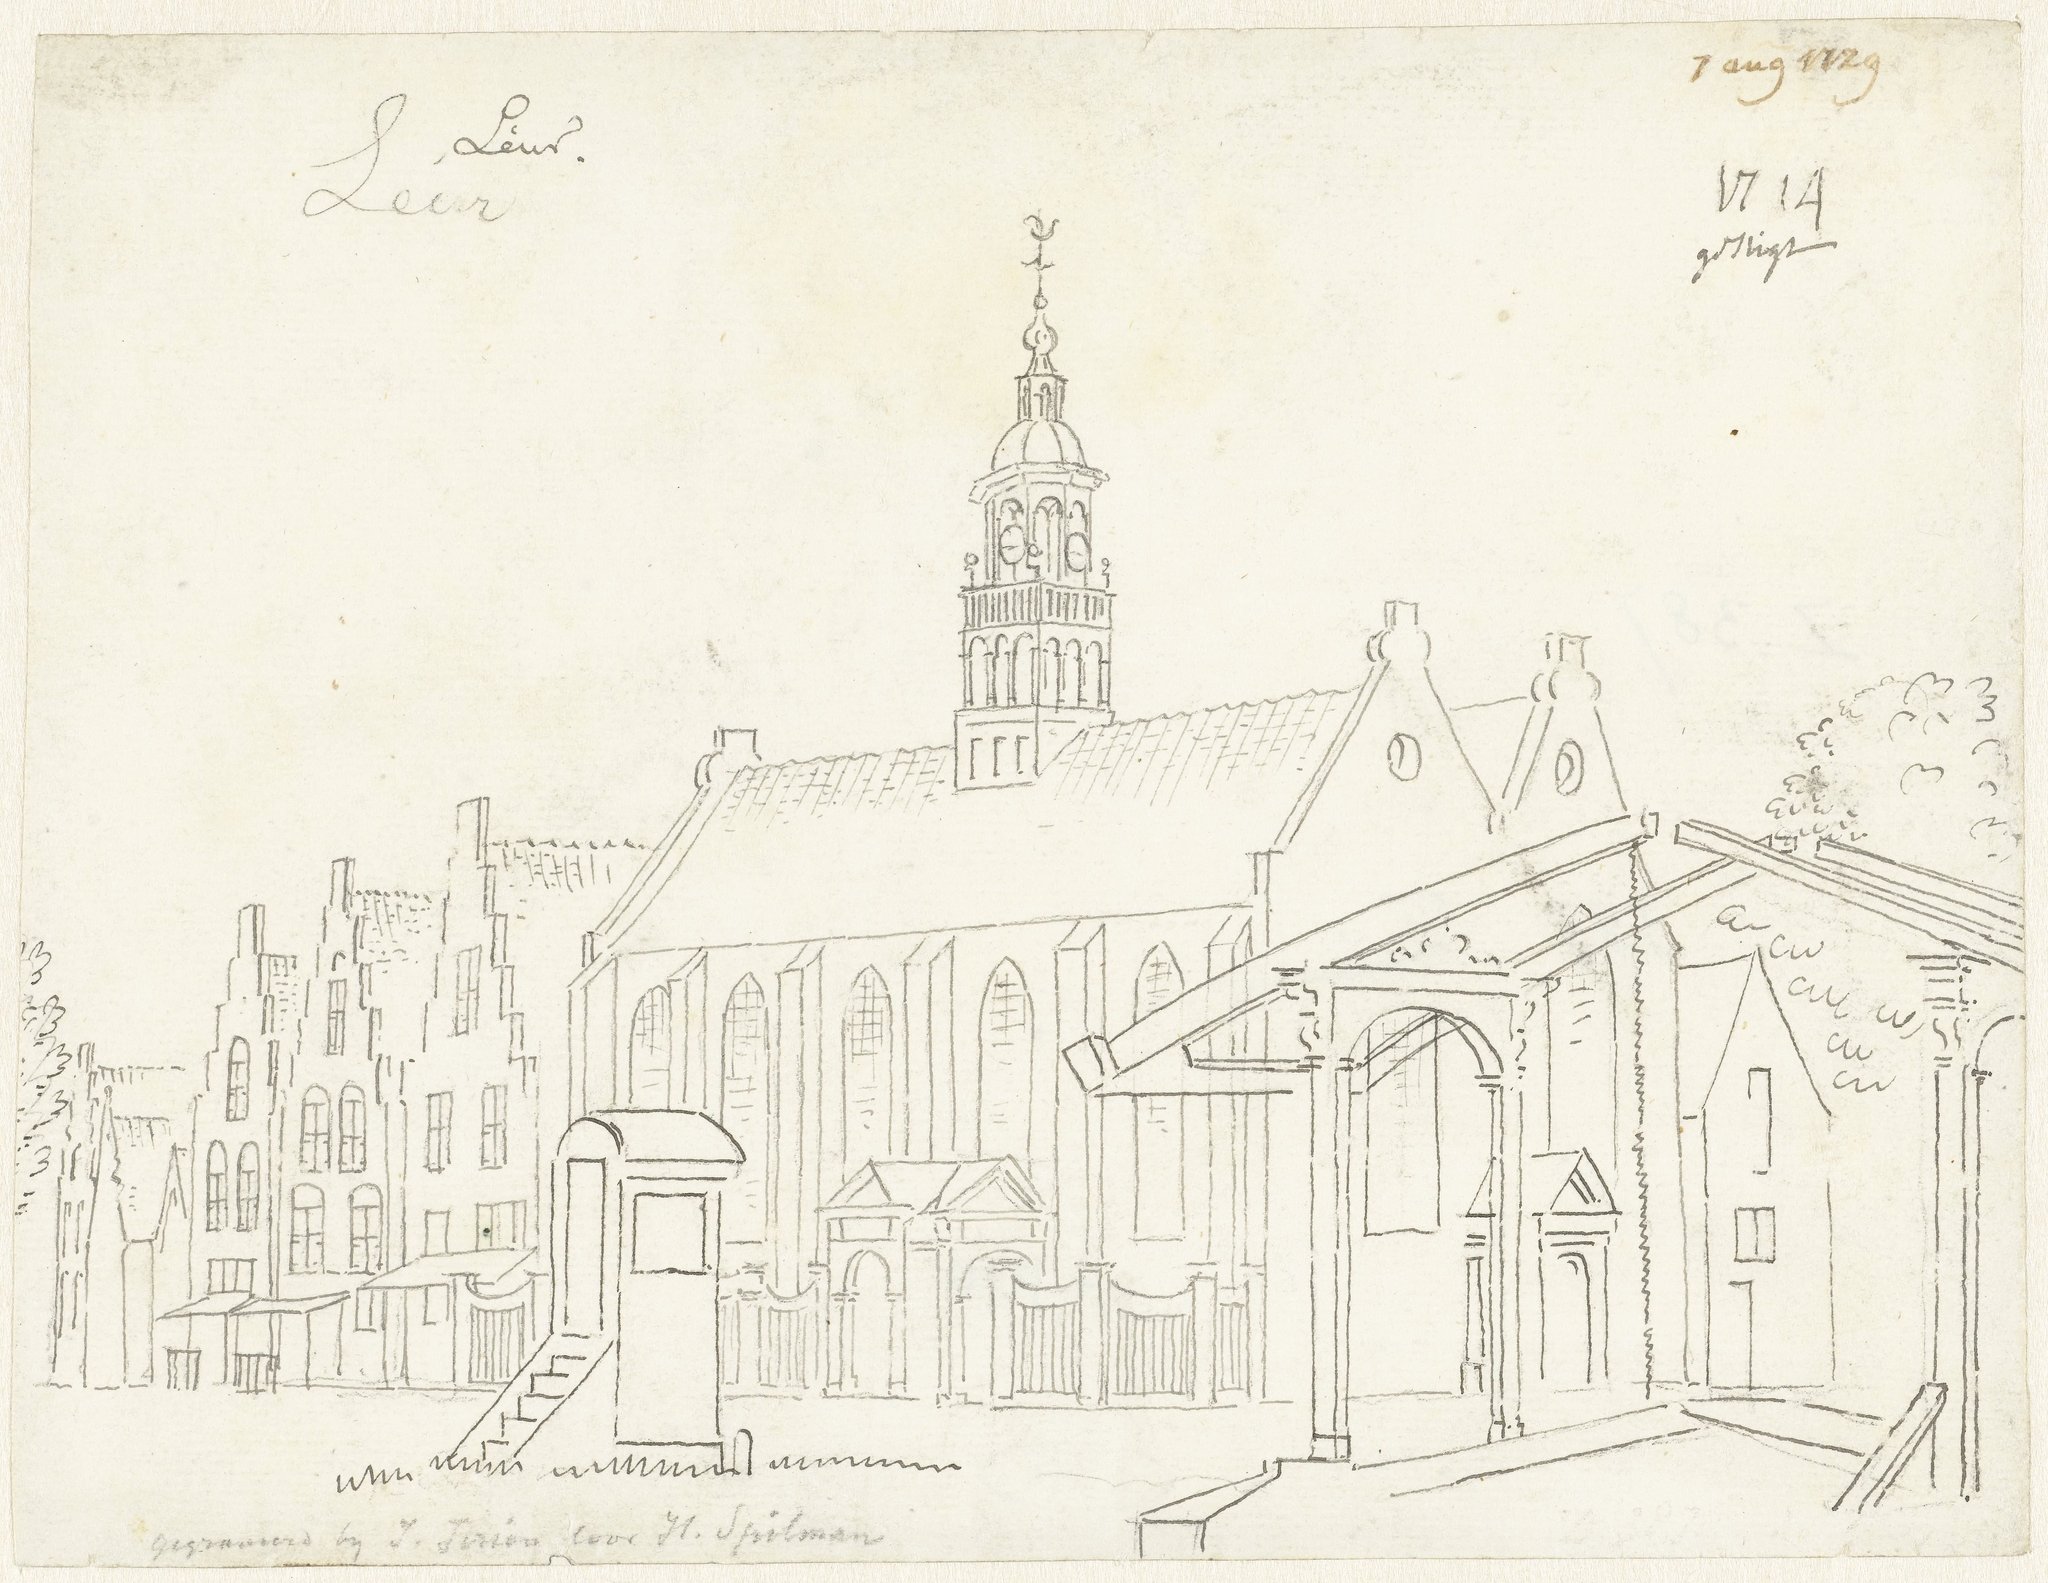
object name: drawing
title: De kerk en een ophaalbrug in het dorp Leur, Brabant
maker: cornelis pronk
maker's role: draughtsman, painter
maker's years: 1691-1759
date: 1729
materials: ink, paper, pencil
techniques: pen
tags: church (exterior), bridge, street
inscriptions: inscription: ‘gegraveerd bij I. Tirion door H. Spilman’, inscription: ‘Leur / Leur / 7 aug 1729 / 1714 gestigt’